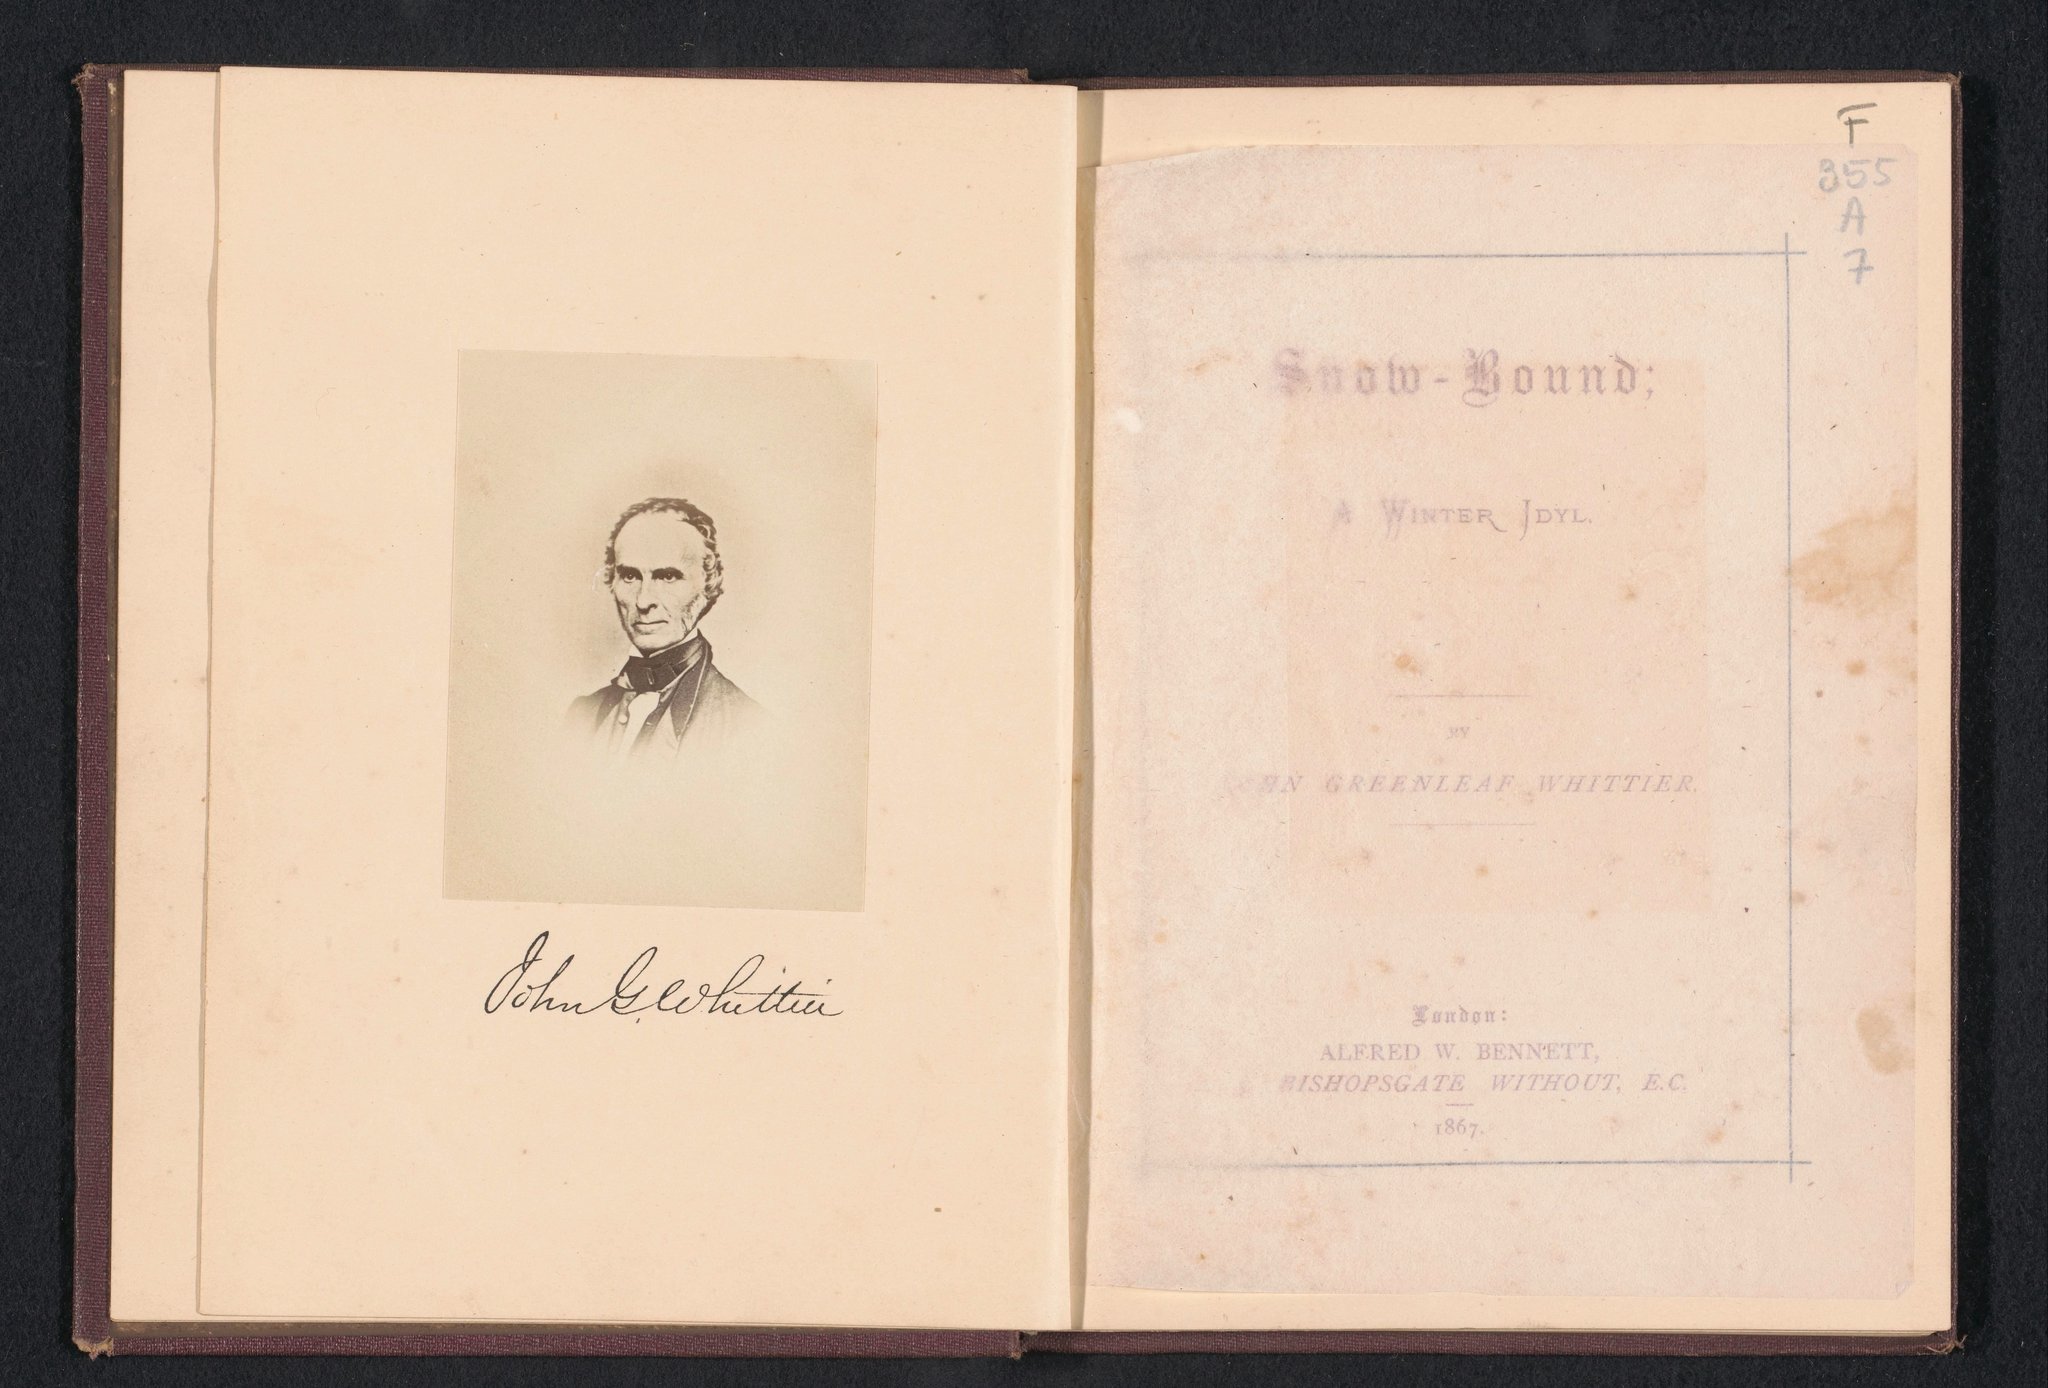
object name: photograph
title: Portret van John Greenleaf Whittier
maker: Anonymous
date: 1862-1867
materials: photographic support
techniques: albumen print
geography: united states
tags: john greenleaf whittier, portrait of a writer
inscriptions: name: ‘John G Whittier’